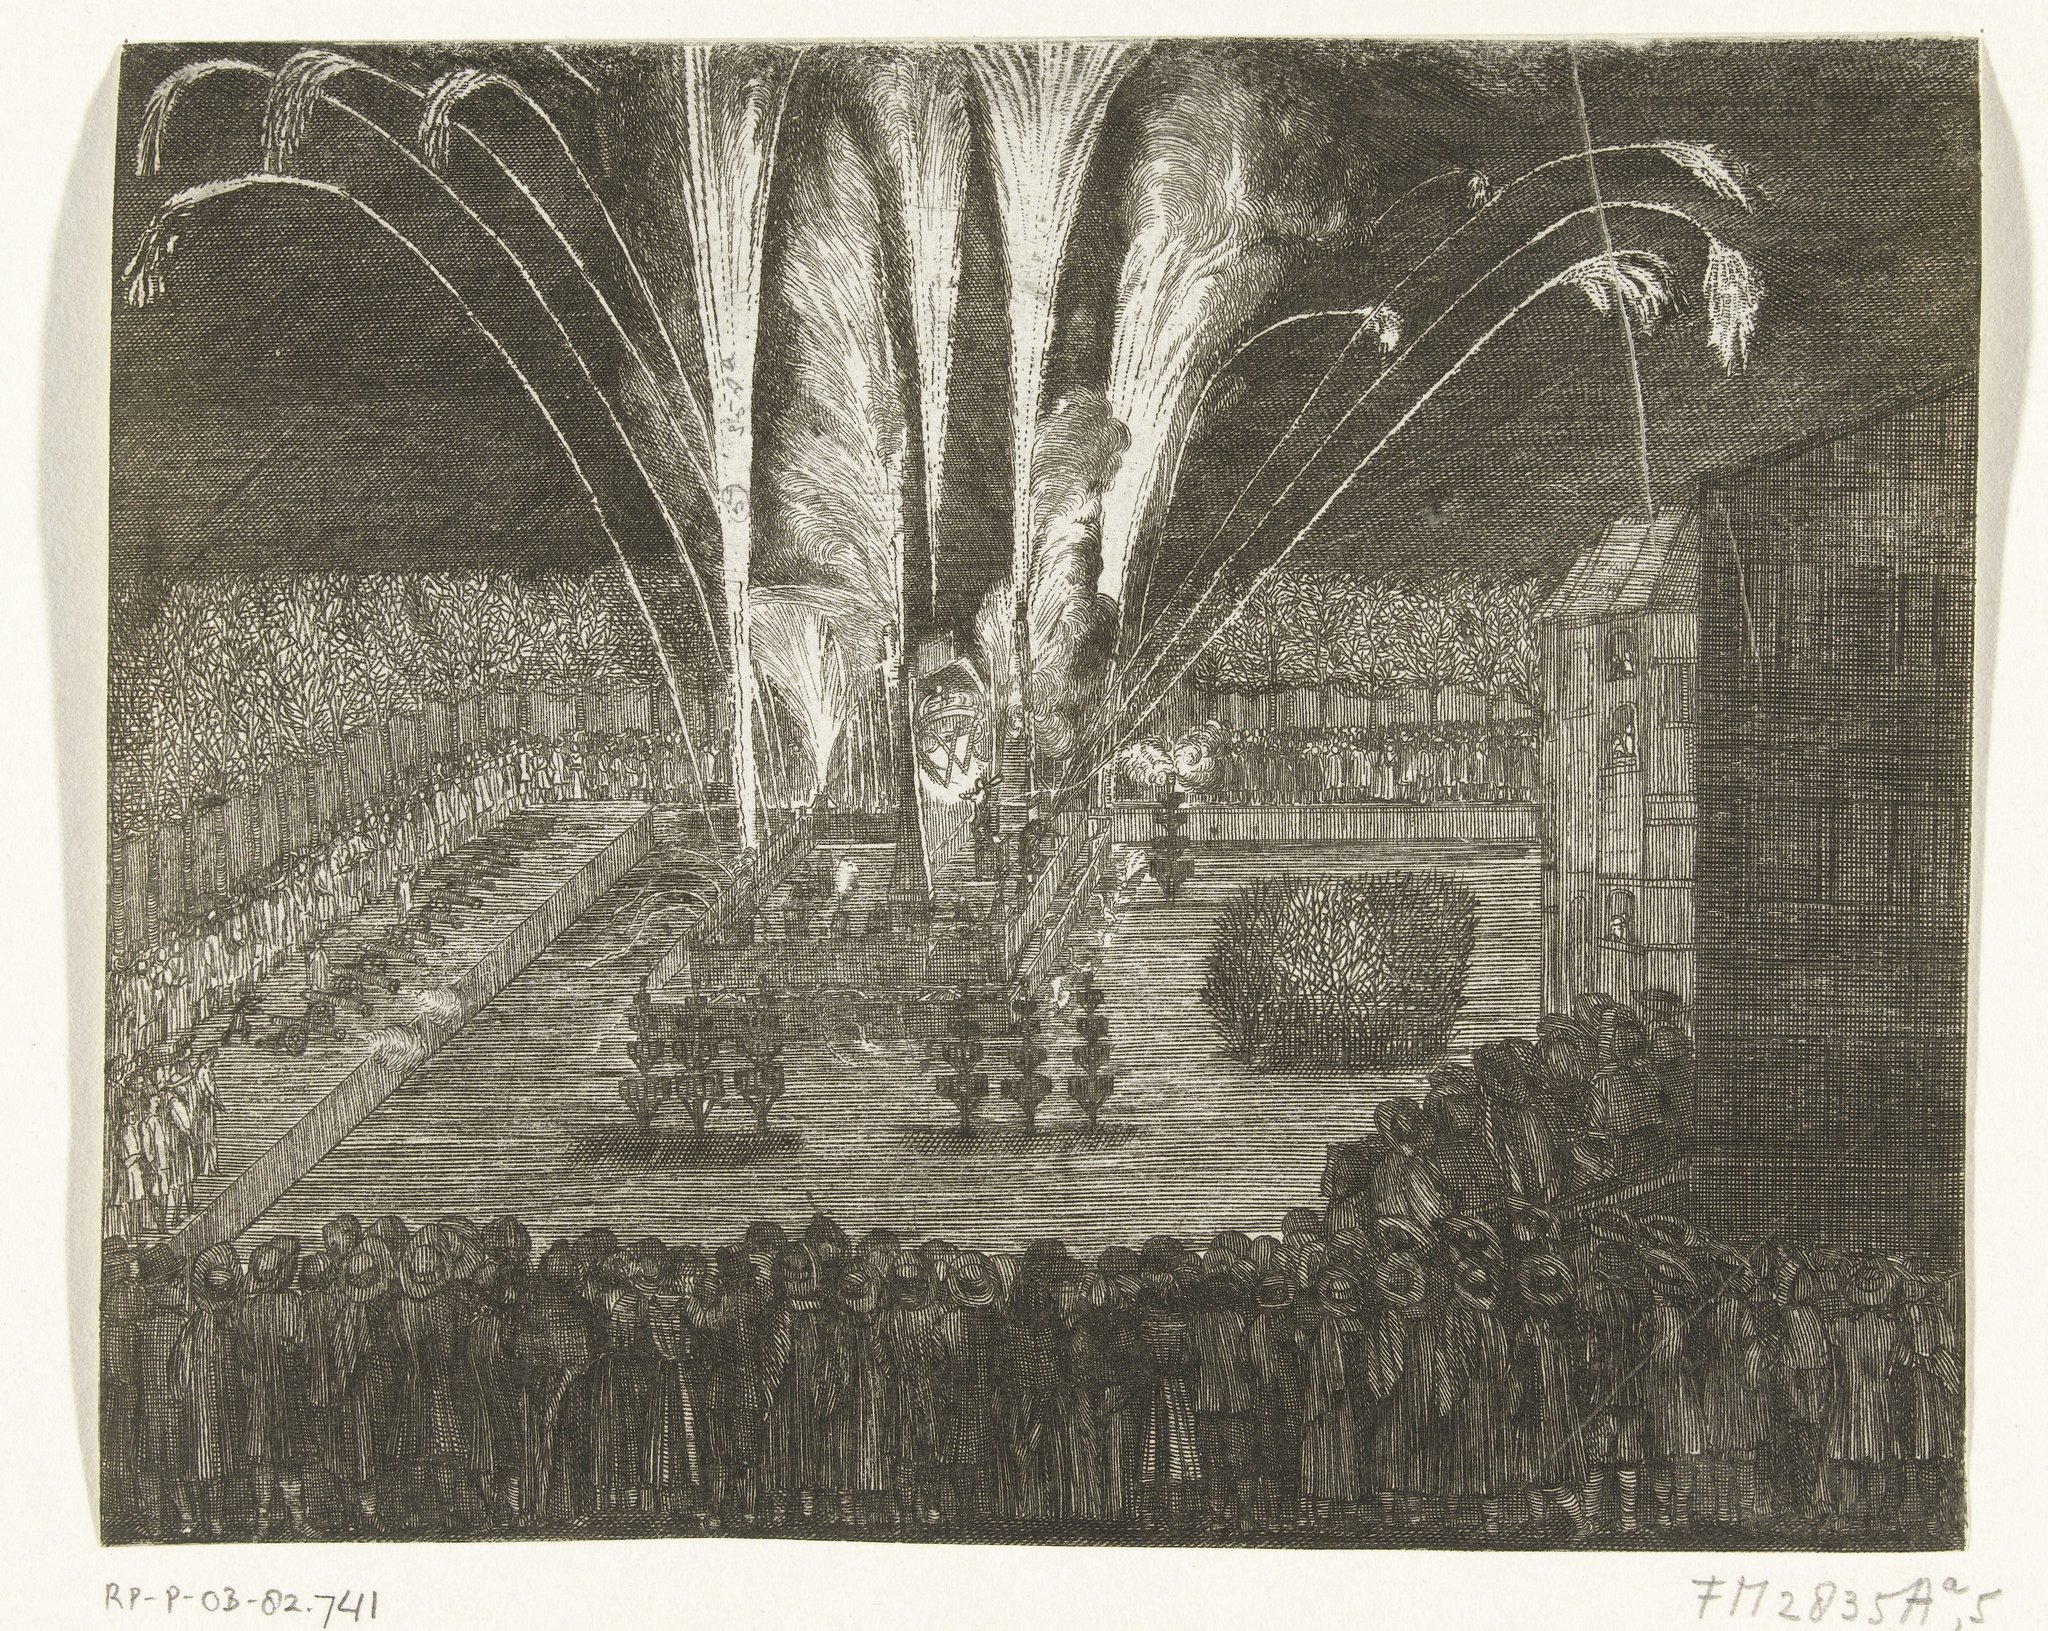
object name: print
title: Vuurwerk bij de intocht van koning Willem III te Den Haag, 1691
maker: Anonymous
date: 1691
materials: paper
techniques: engraving, etching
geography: northern netherlands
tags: william iii (prince of orange and king of england, scotland, and ireland), bonfire, fire-works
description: Vuurwerk afgestoken op het water van de Hofvijver bij de intocht van koning Willem III te Den Haag, 5 februari 1691.